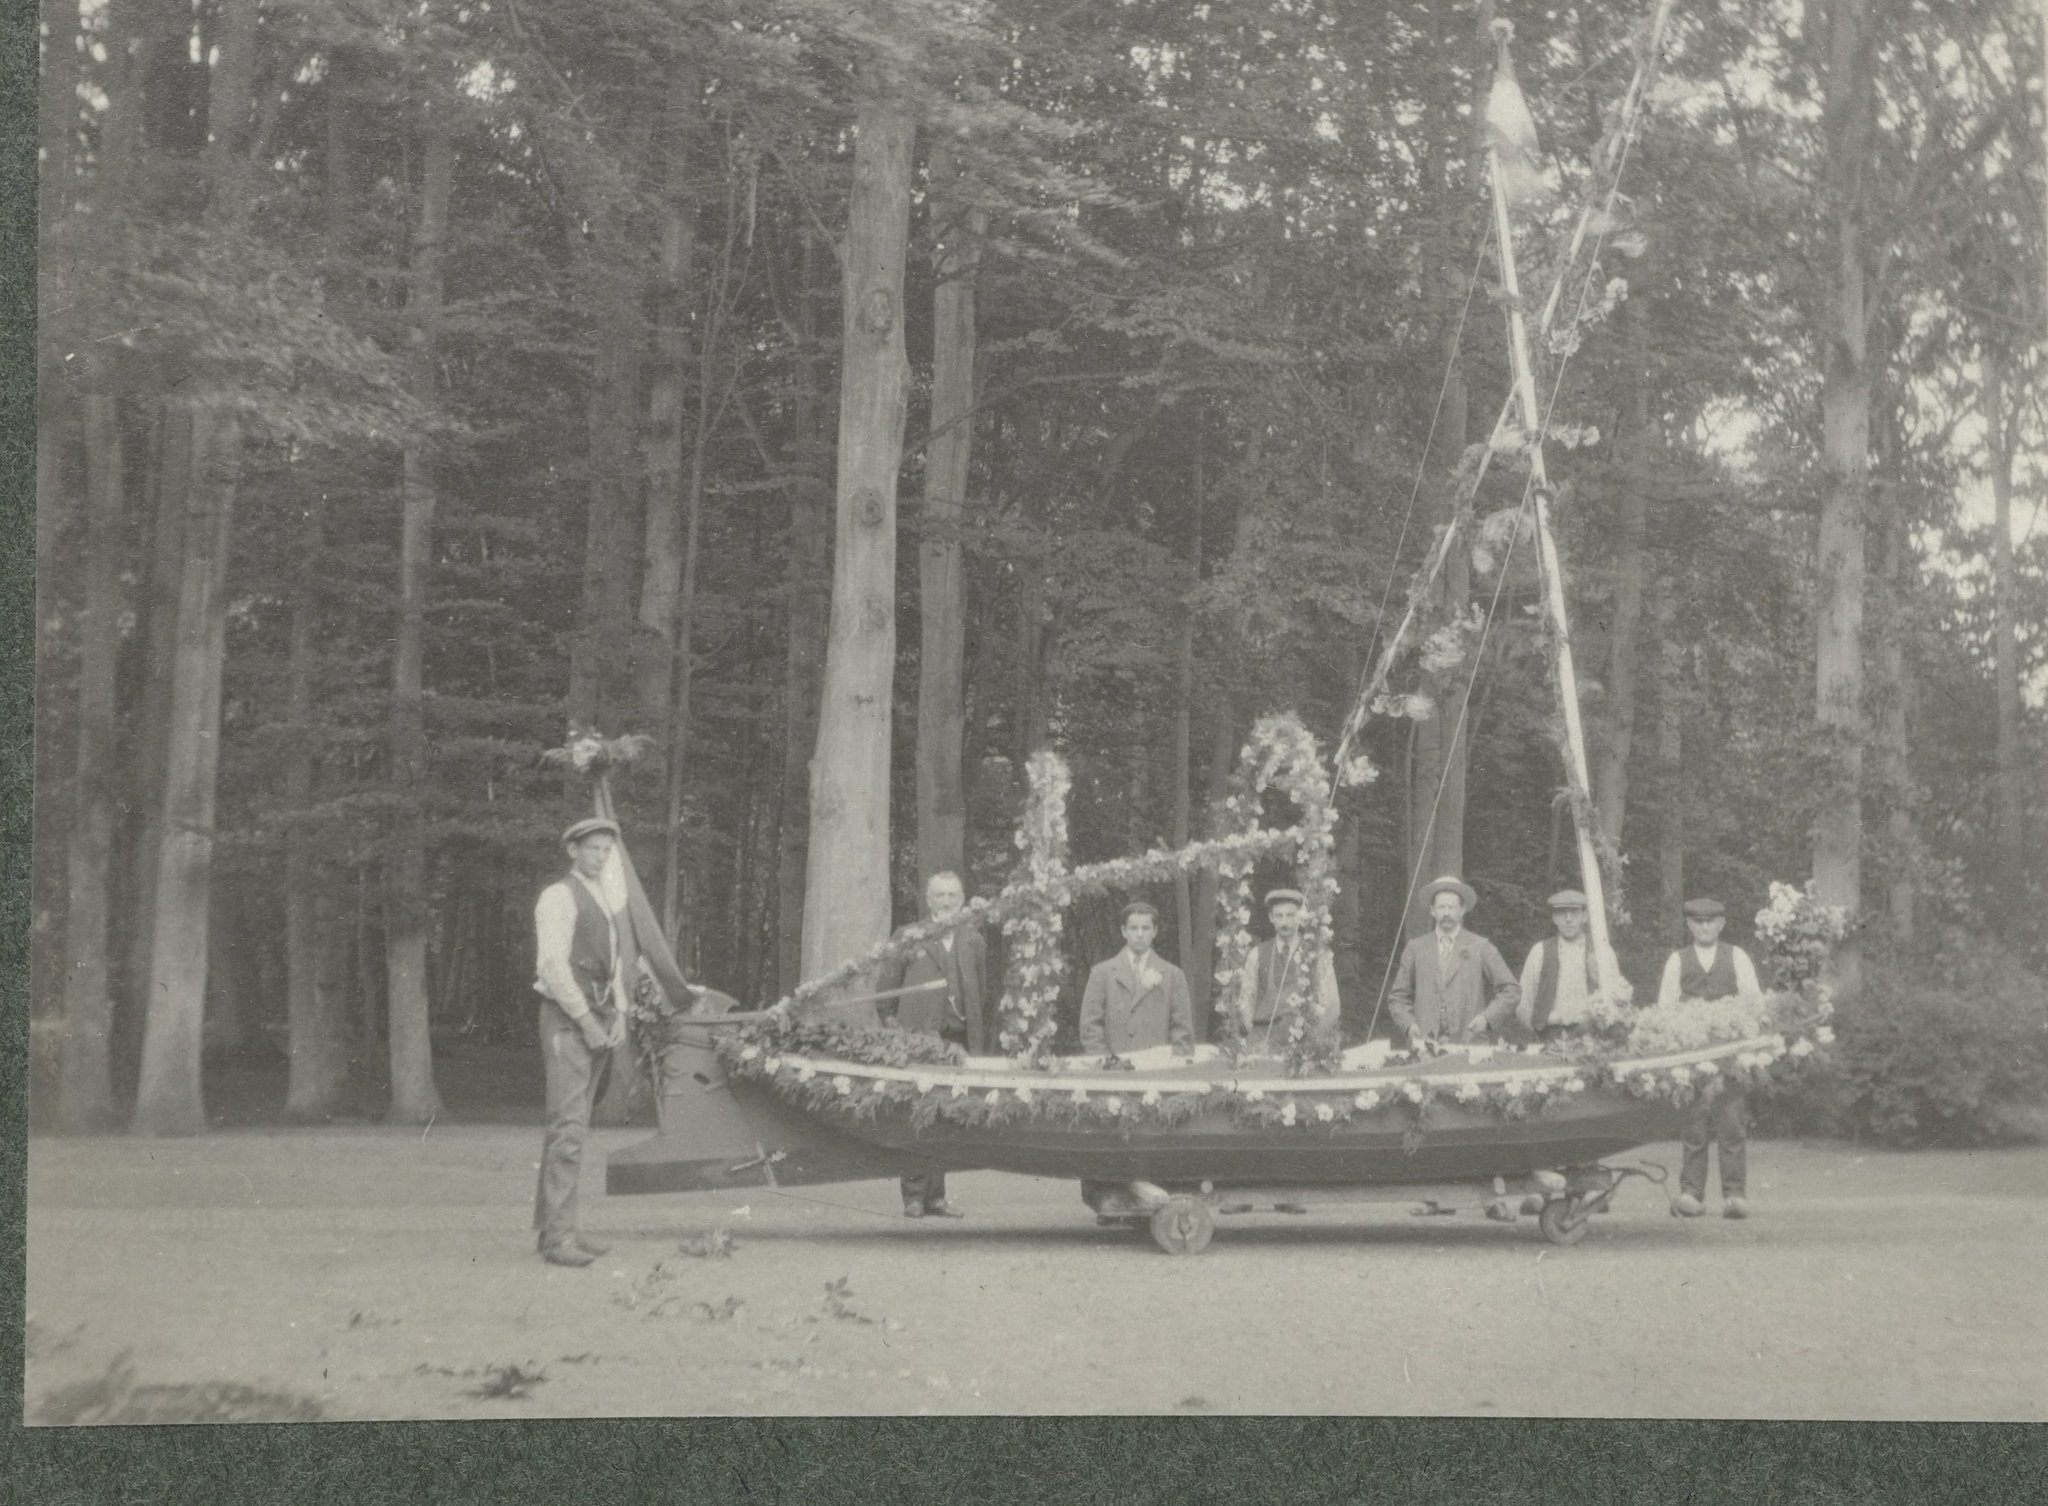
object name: photograph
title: Groep mannen bij een versierde boot op Landgoed De Paauw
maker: geldolph adriaan kessler (dolph)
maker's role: fotograaf, industrieel, voetballer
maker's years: 1884-1945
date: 1913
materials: paper, photographic support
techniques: gelatin silver print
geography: netherlands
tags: huize de paauw